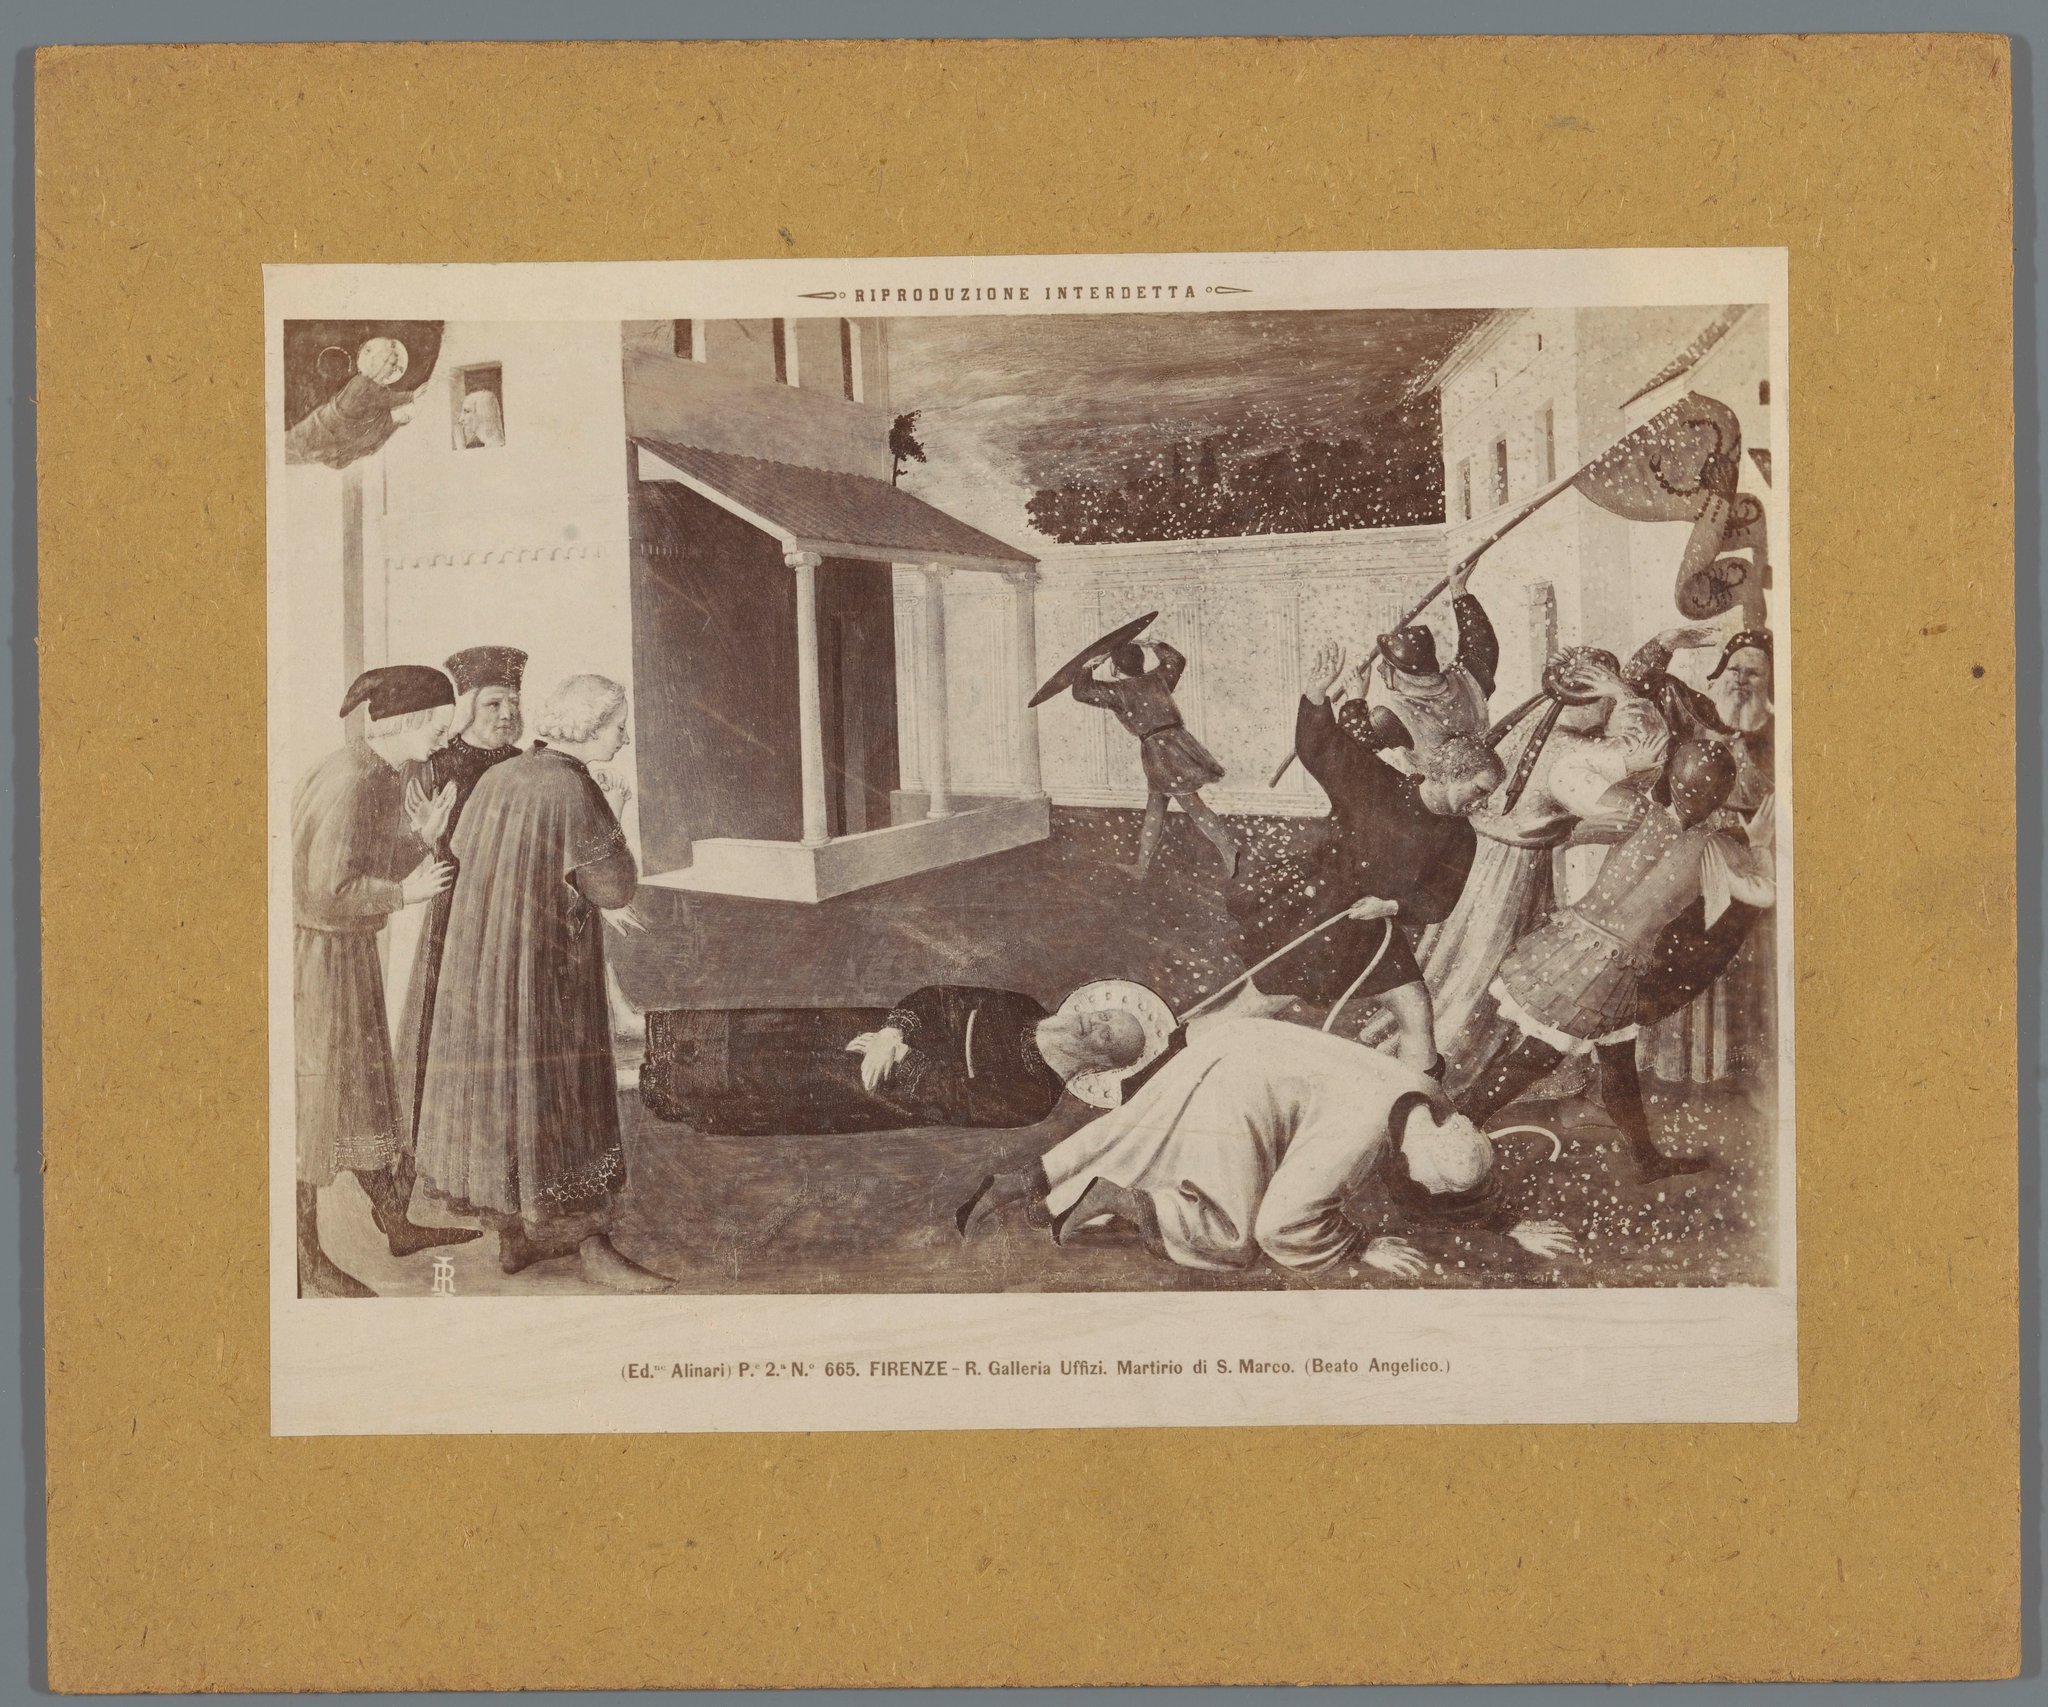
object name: reproduction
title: Fotoreproductie van een schilderij door Fra Angelico, voorstellende het martelaarschap van de heilige Marcus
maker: fra angelico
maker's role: painter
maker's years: 1400-1455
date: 1875-1900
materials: cardboard, photographic support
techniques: albumen print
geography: italy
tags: during a hailstorm st. mark is dragged through the streets of alexandria with a rope round his neck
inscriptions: number: ‘P.e 2.a N.o 665.’, inscription:, collector's mark: Lugt 3937